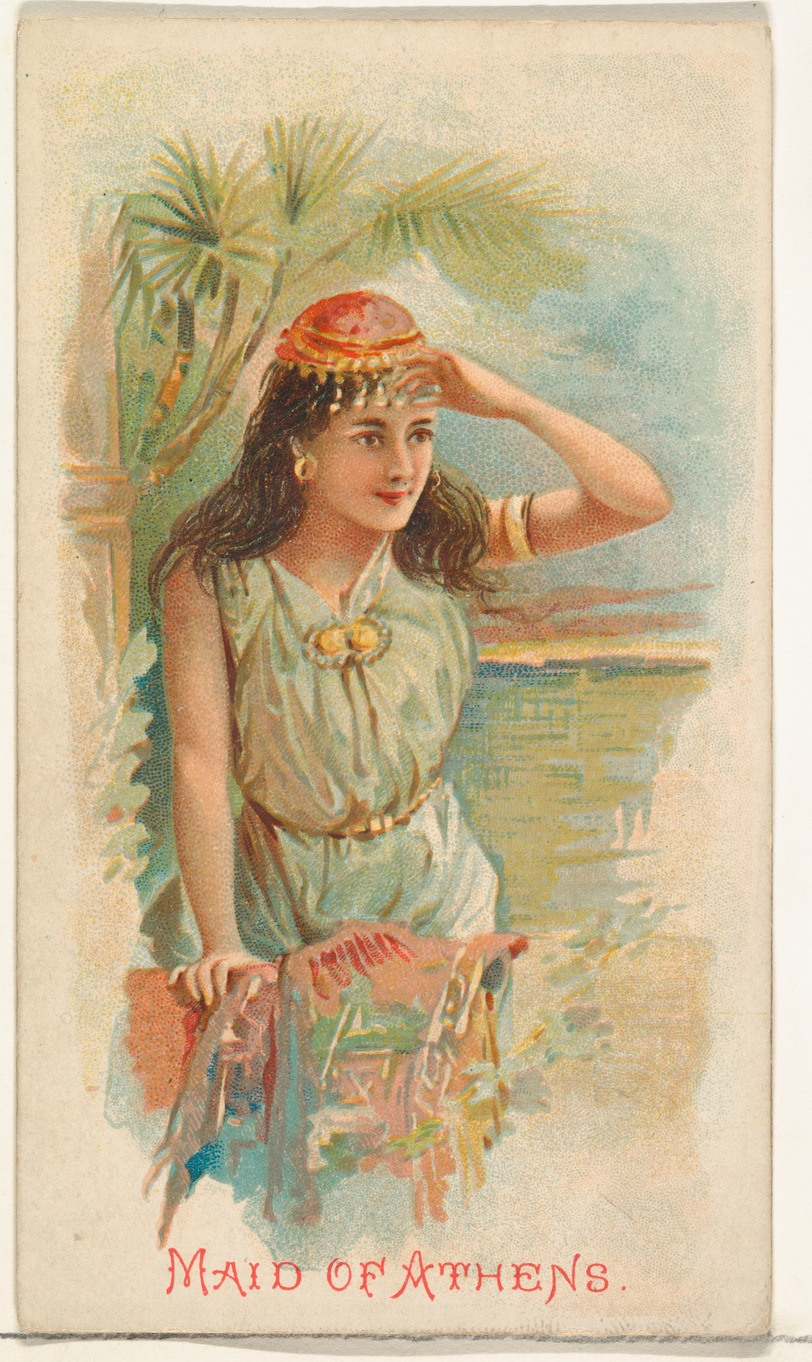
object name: print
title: Maid of Athens, from the Illustrated Songs series (N116) issued by W. Duke, Sons & Co. to promote Honest Long Cut Tobacco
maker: w. duke, sons & co.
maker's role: publisher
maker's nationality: american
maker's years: 1870-1920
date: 1893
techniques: color lithograph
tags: women